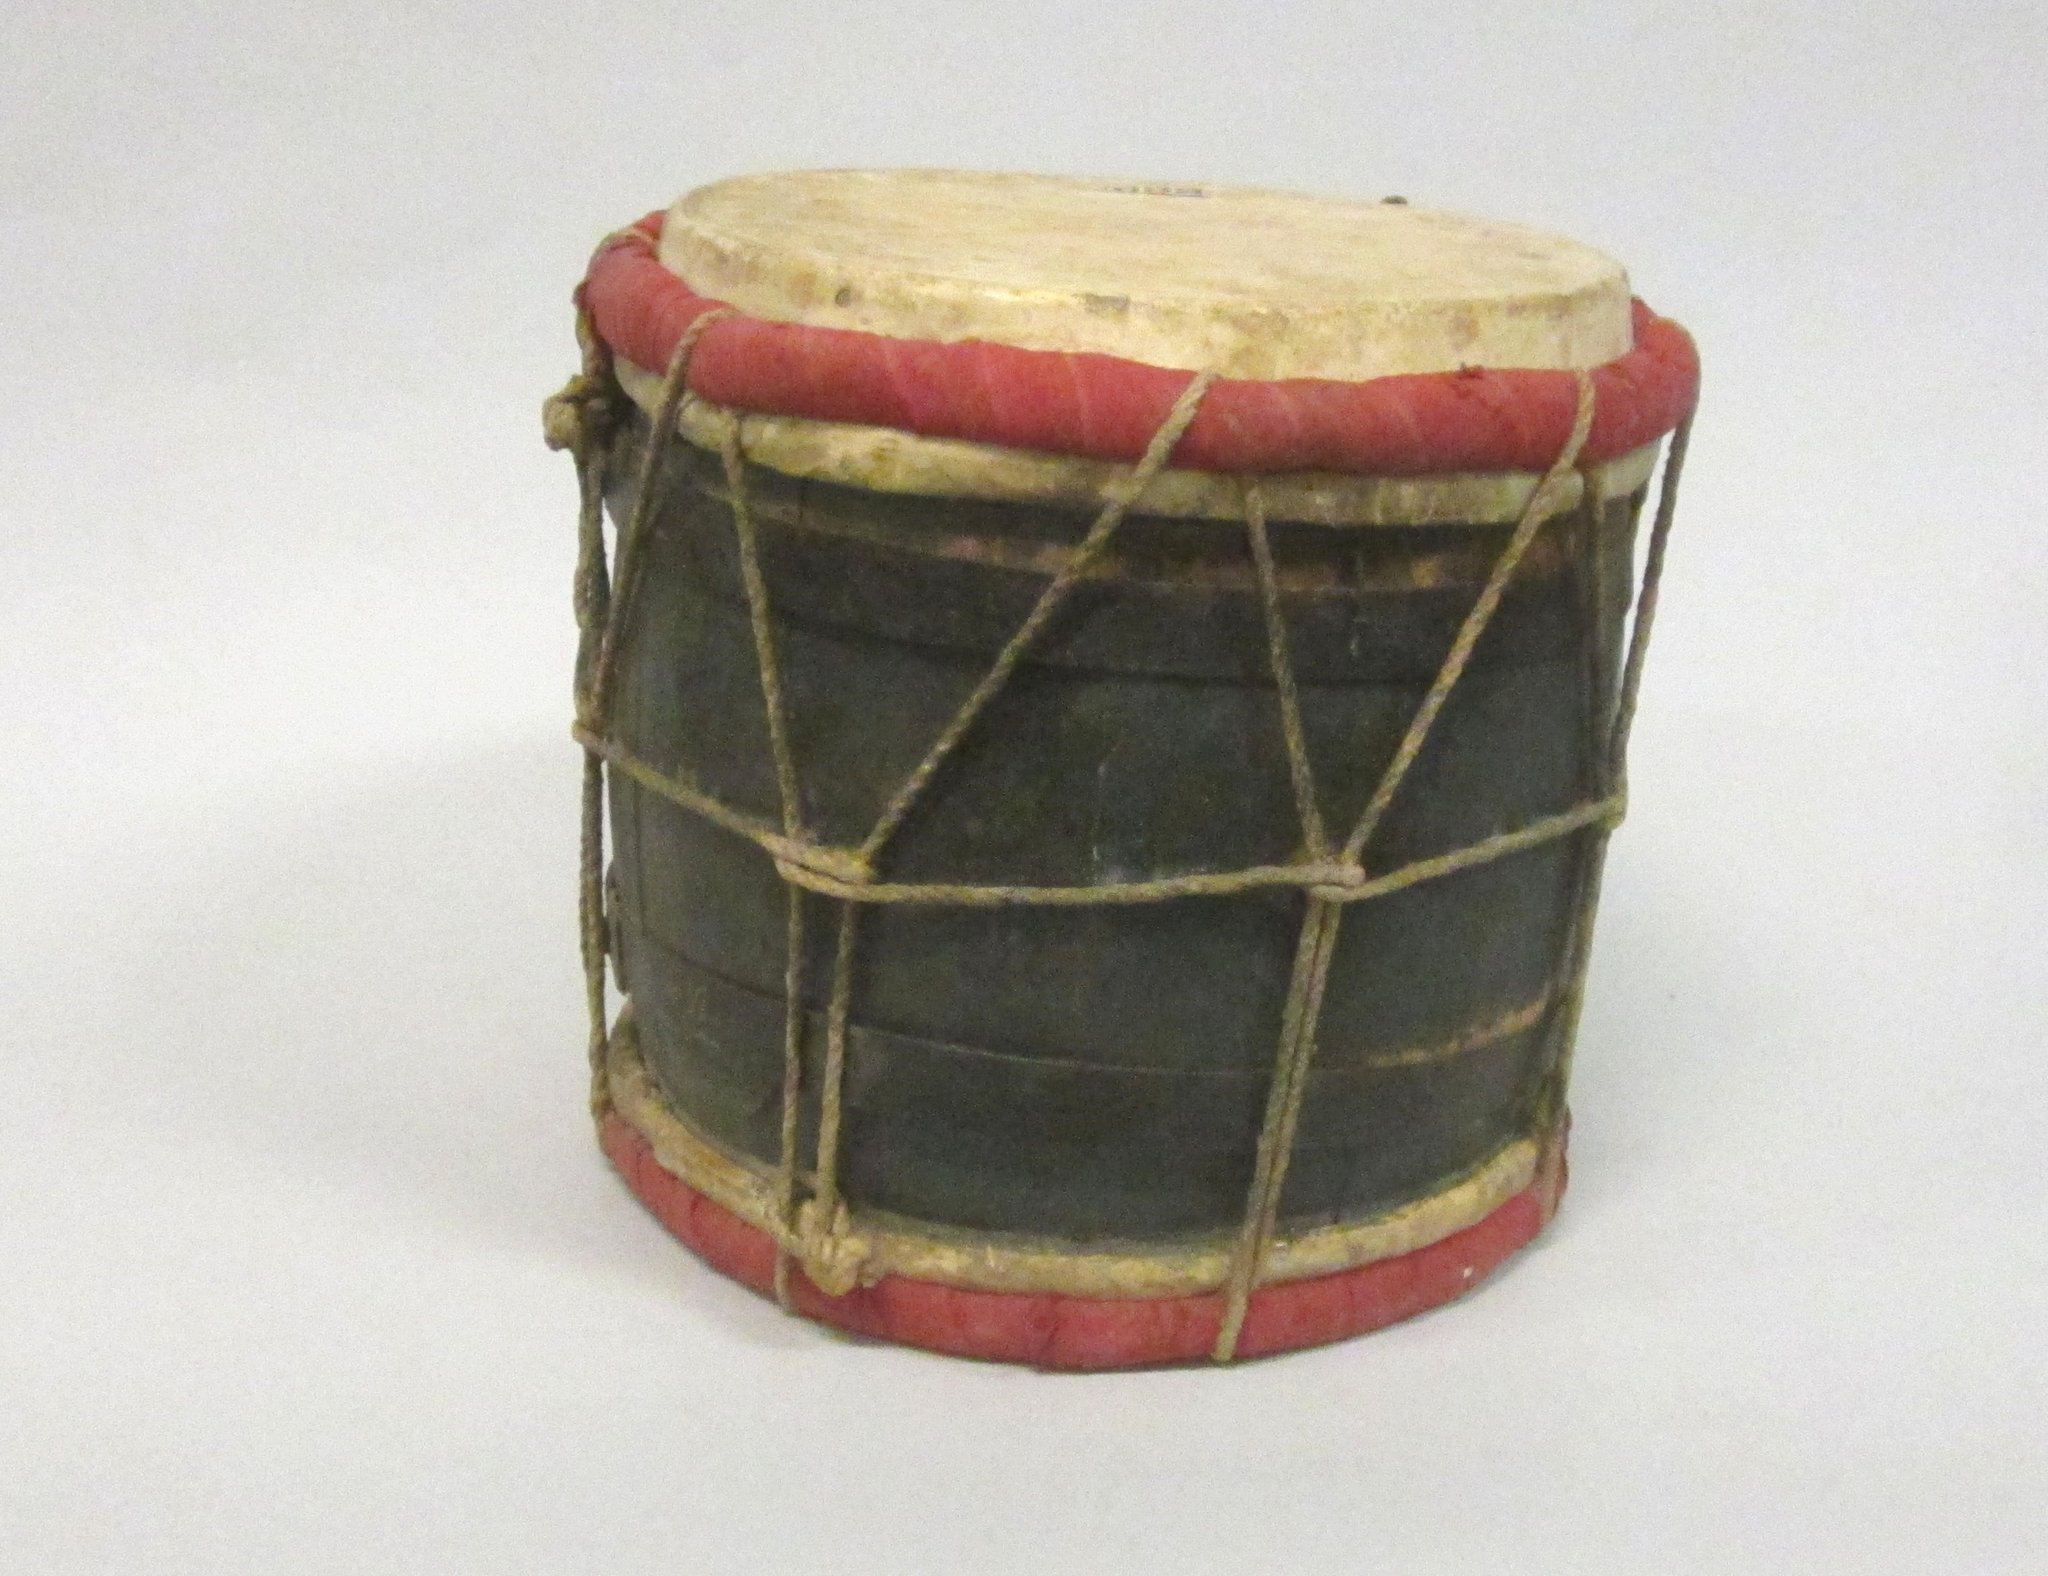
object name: tabona drum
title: Tabona (drum)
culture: cuban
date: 1867-1900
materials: skin, wood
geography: cuba